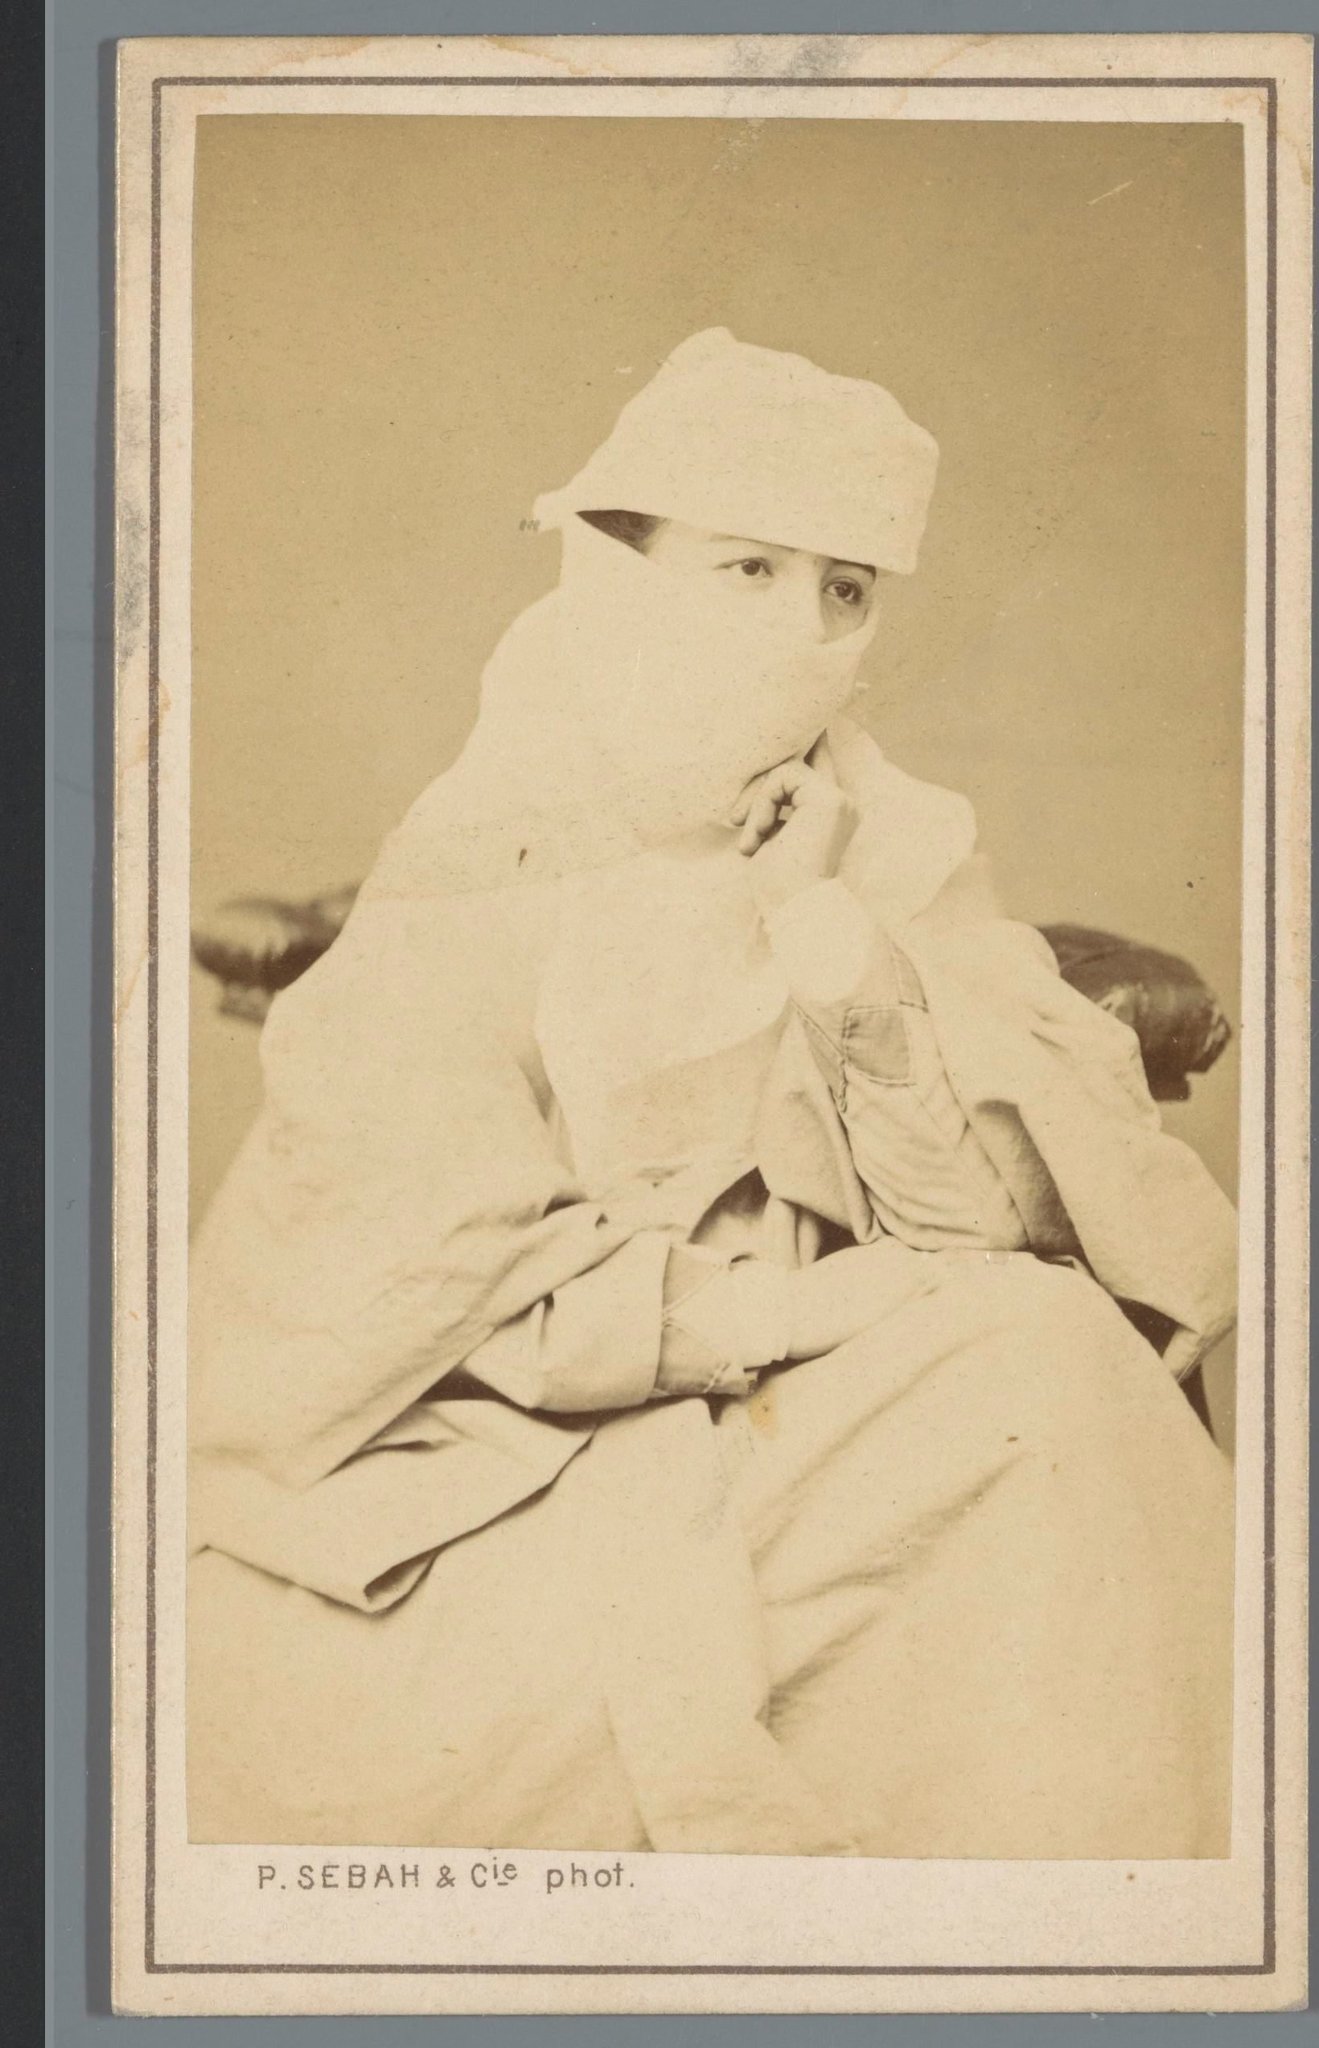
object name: photograph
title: Femme turque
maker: pascal sébah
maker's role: fotograaf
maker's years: 1823-1886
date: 1857-1886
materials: cardboard, paper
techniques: albumen print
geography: constantinople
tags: anonymous historical person portrayed, veil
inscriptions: inscription: ‘L'Imperiale/ P. Sebah & Cie/ photographes/ Rue Tom-Tom/ No. 10./ Près les Postes Autrichienne/ & Française,/ Constantinople./ Panorama, vues,/ costumes, stereo-/ scopes, orientaux.’, inscription: ‘P. Sebah & Cie phot.’